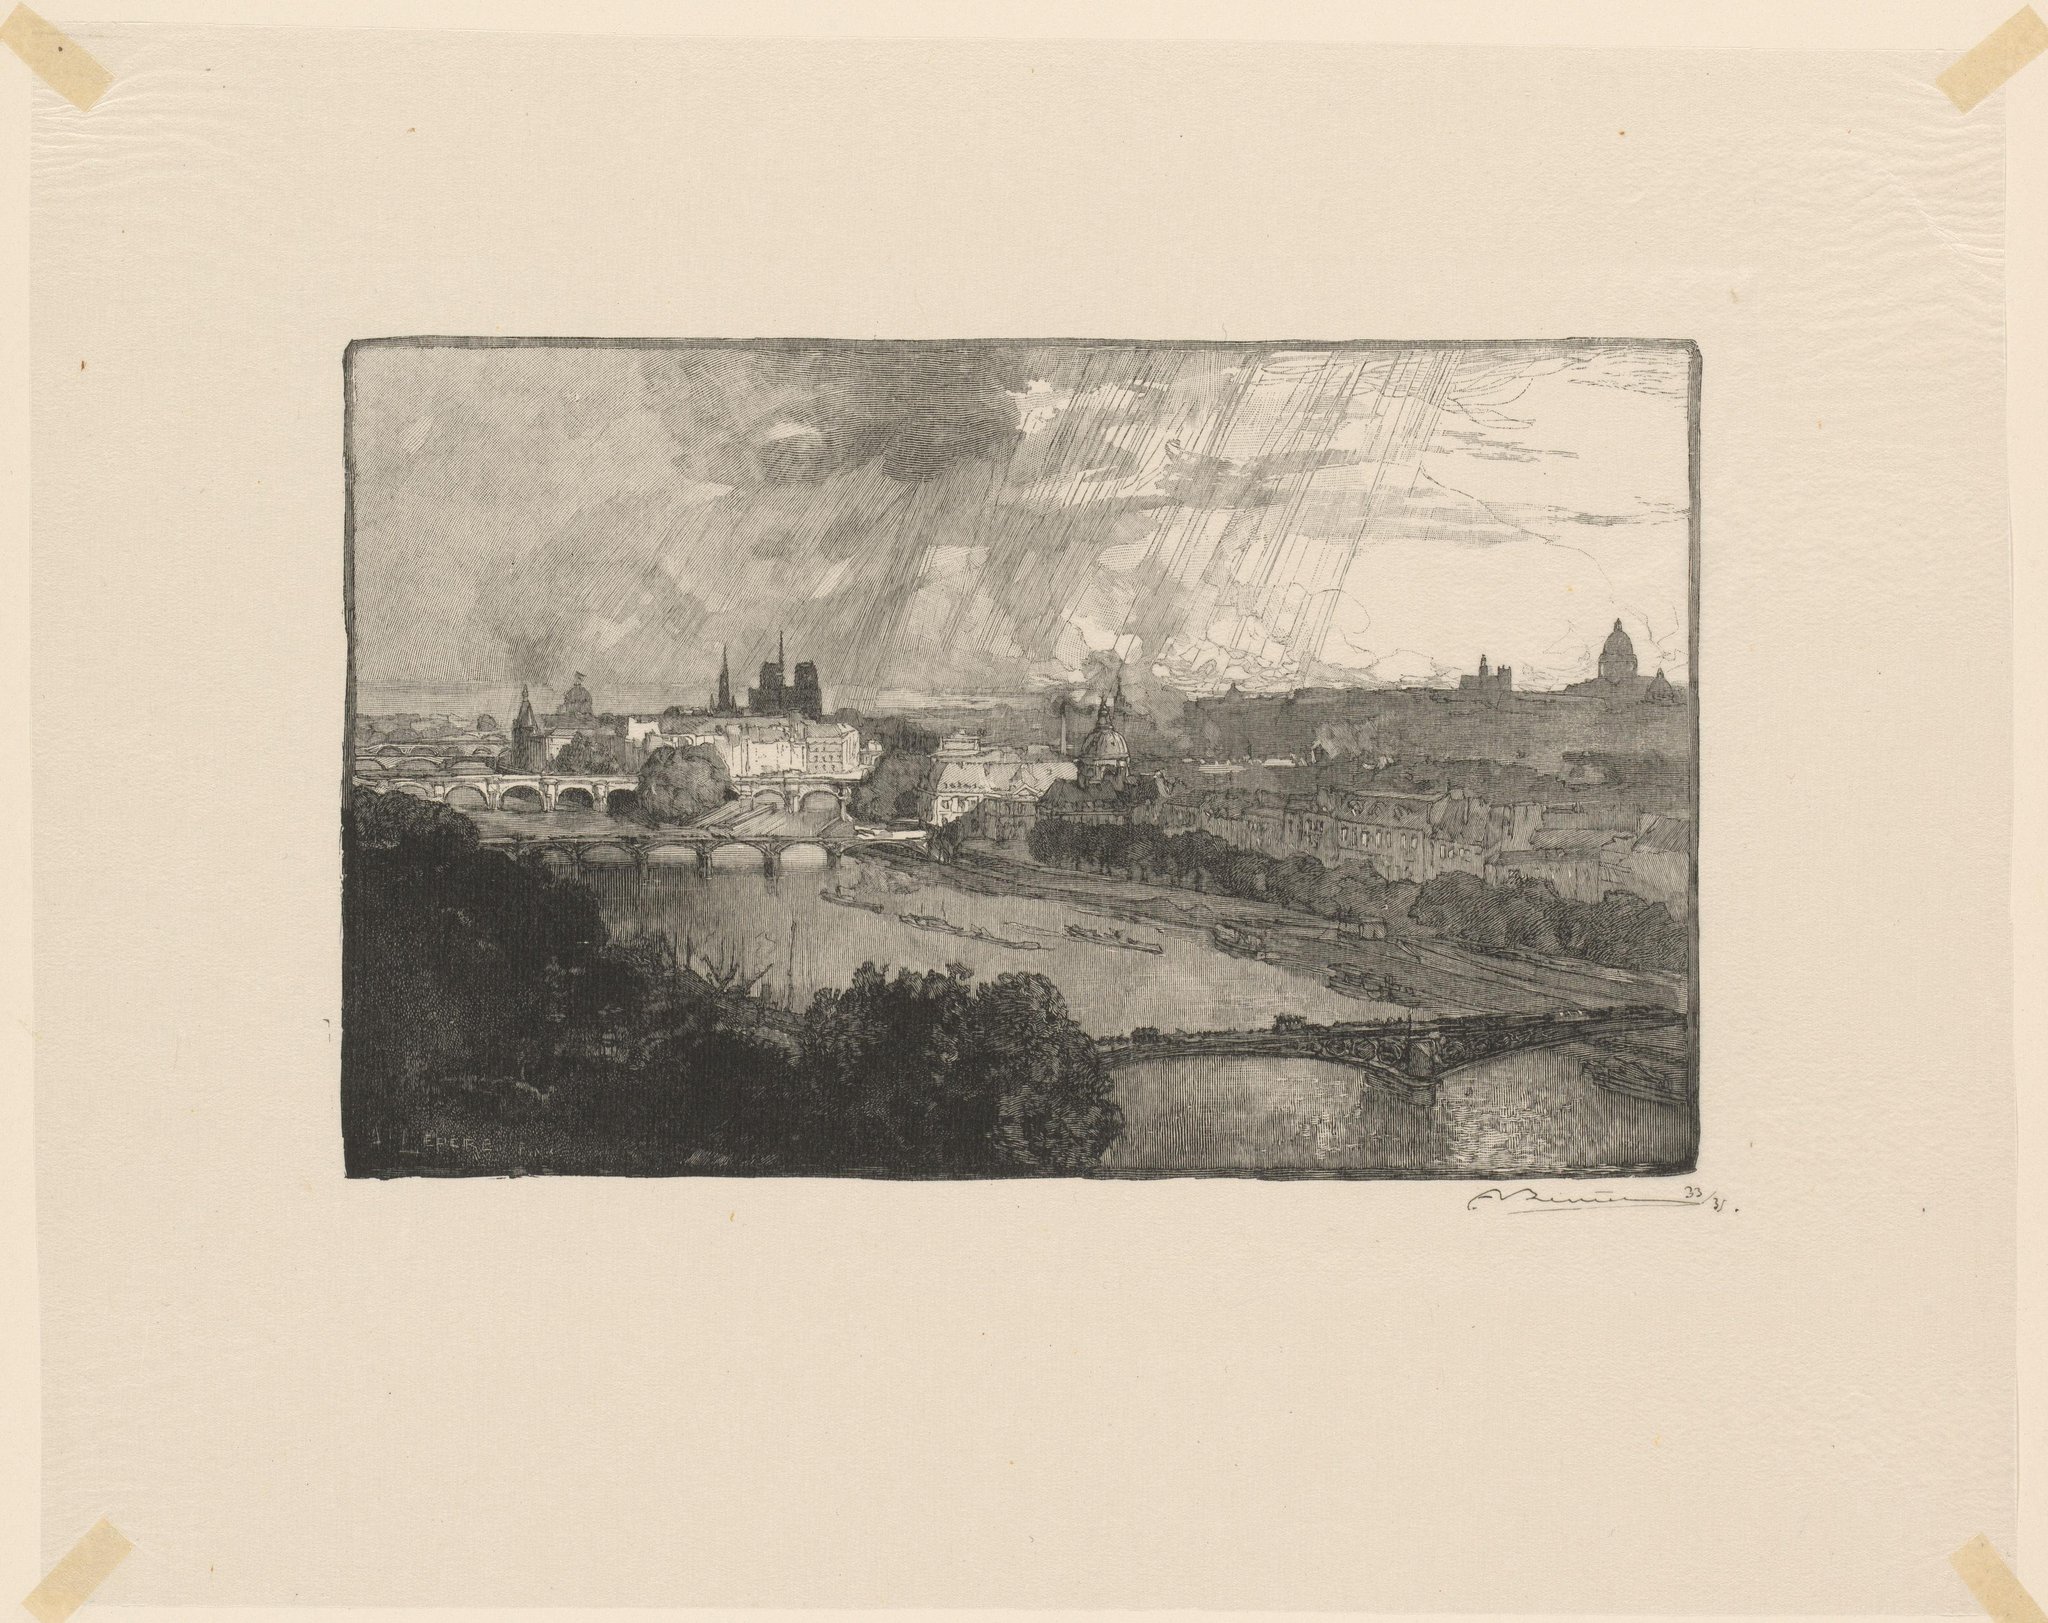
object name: print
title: Le long de la Seine et des boulevards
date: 1910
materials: paper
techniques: engraving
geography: paris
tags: bridge in city across river, canal, etc., prospect of city, town panorama, silhouette of city, paris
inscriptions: collector's mark: Lugt 2228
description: Deze serie heeft als titel 'Le long de la Seine et des boulevards'. Deze serie is het vierde deel van het grotere geheel 'L'Oeuvre gravé sur bois de Auguste Lepère'.